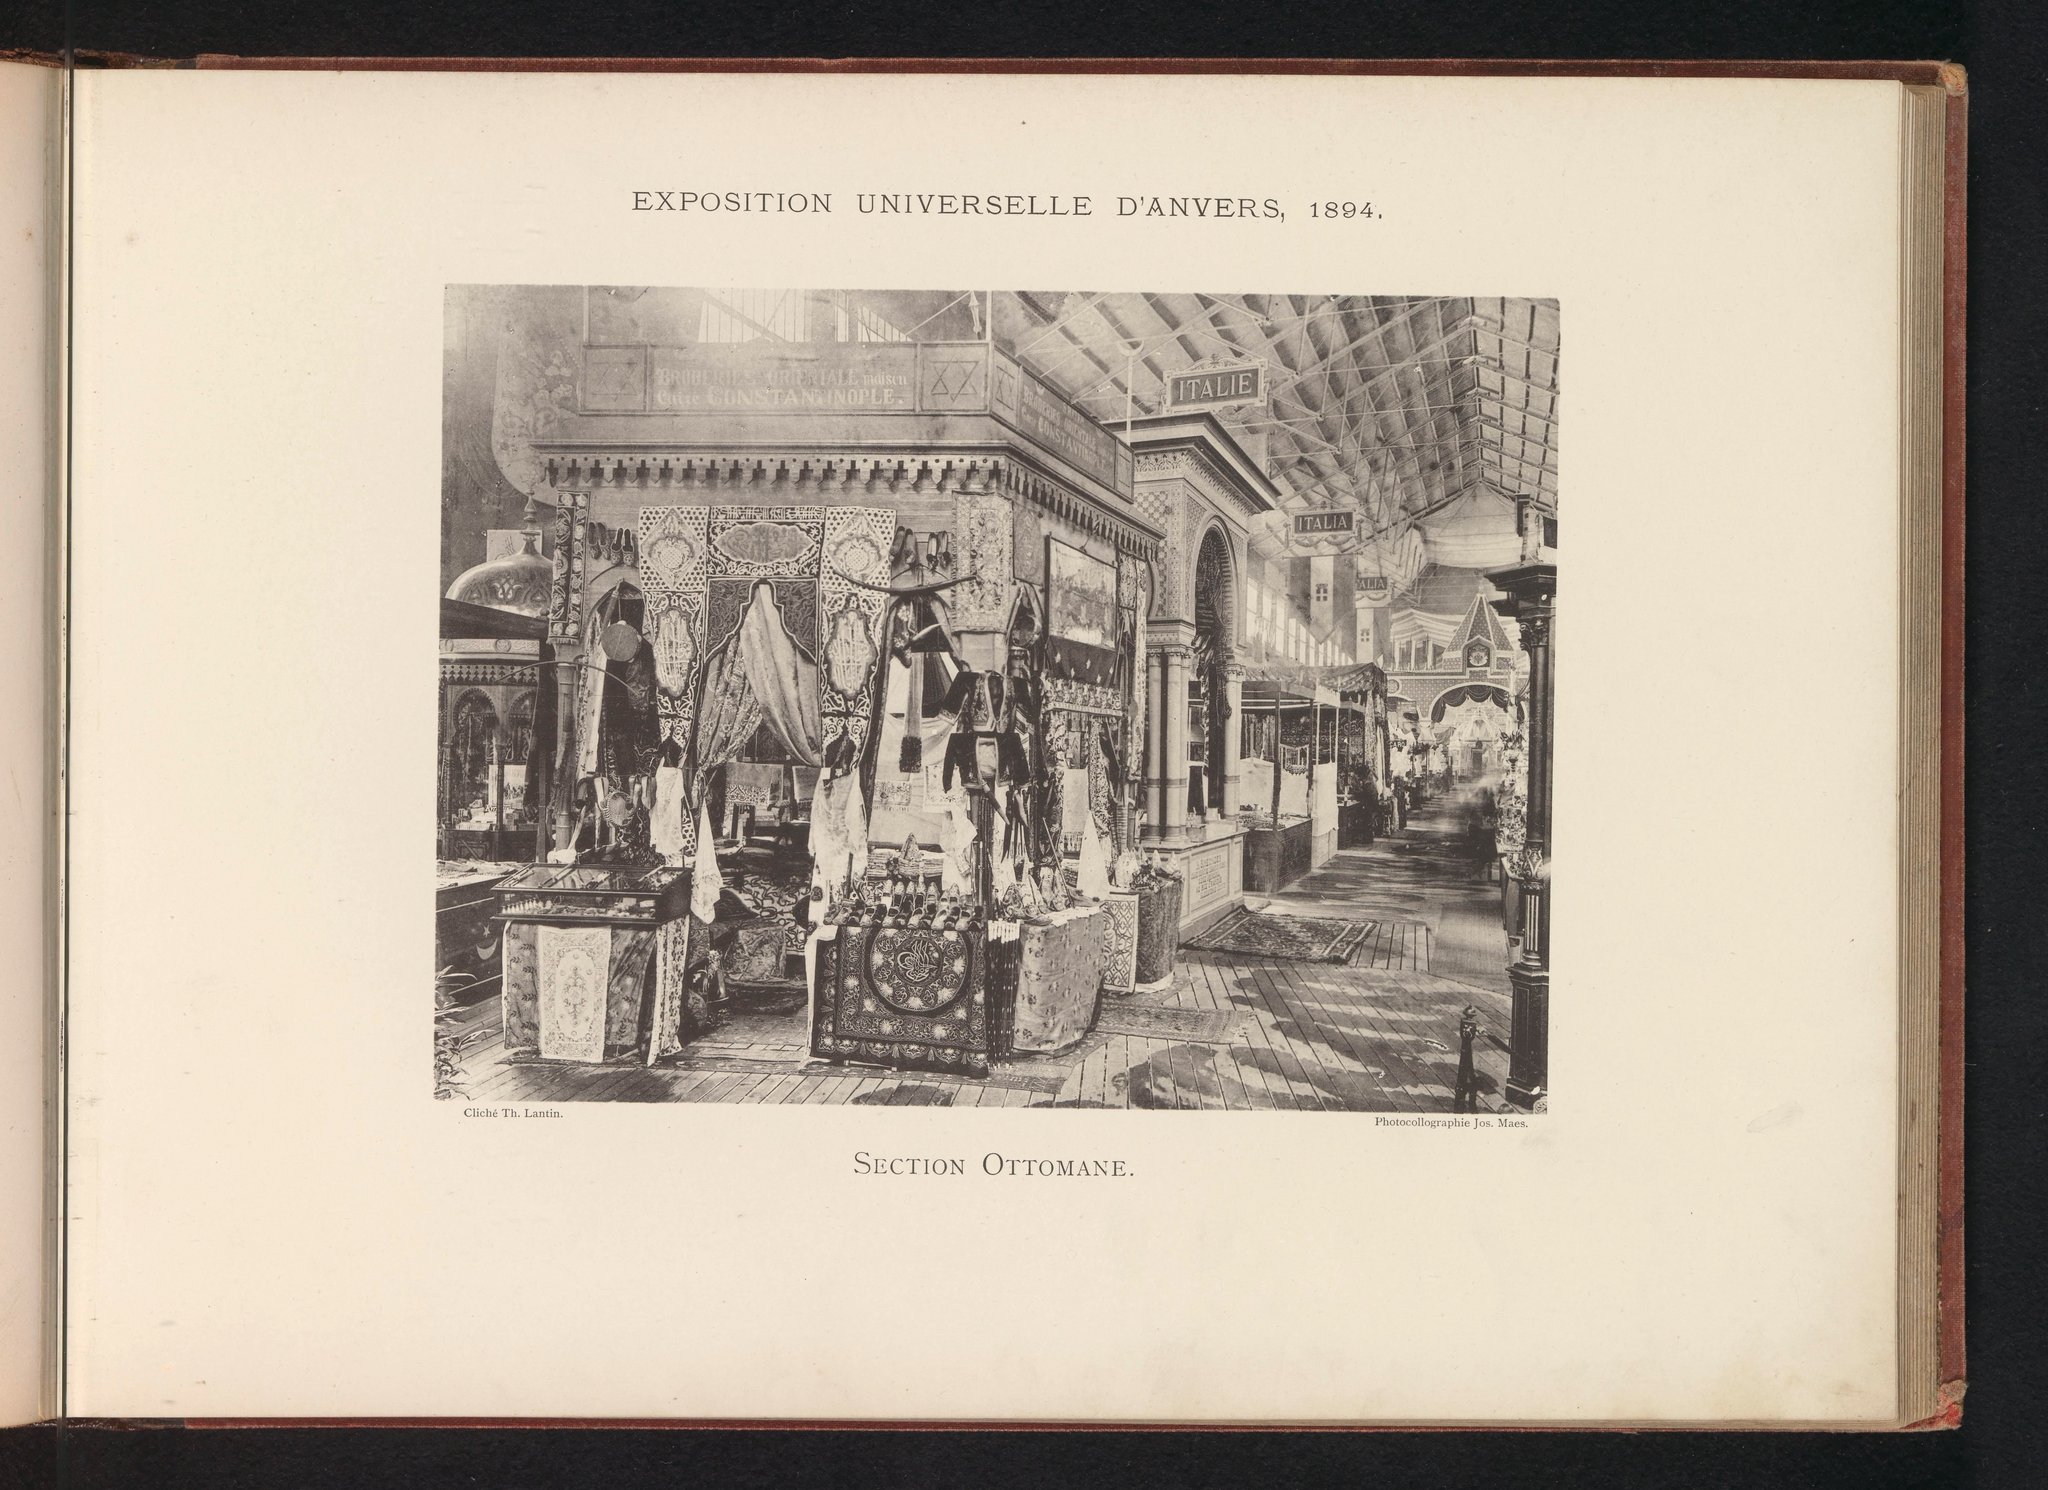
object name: photomechanical print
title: Expositie van Ottomaanse objecten tijdens de wereldtentoonstelling te Antwerpen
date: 1894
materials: paper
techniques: photograph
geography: antwerp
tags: world fair, world exhibition, interior ~ representation of a building, collection, exhibition, show